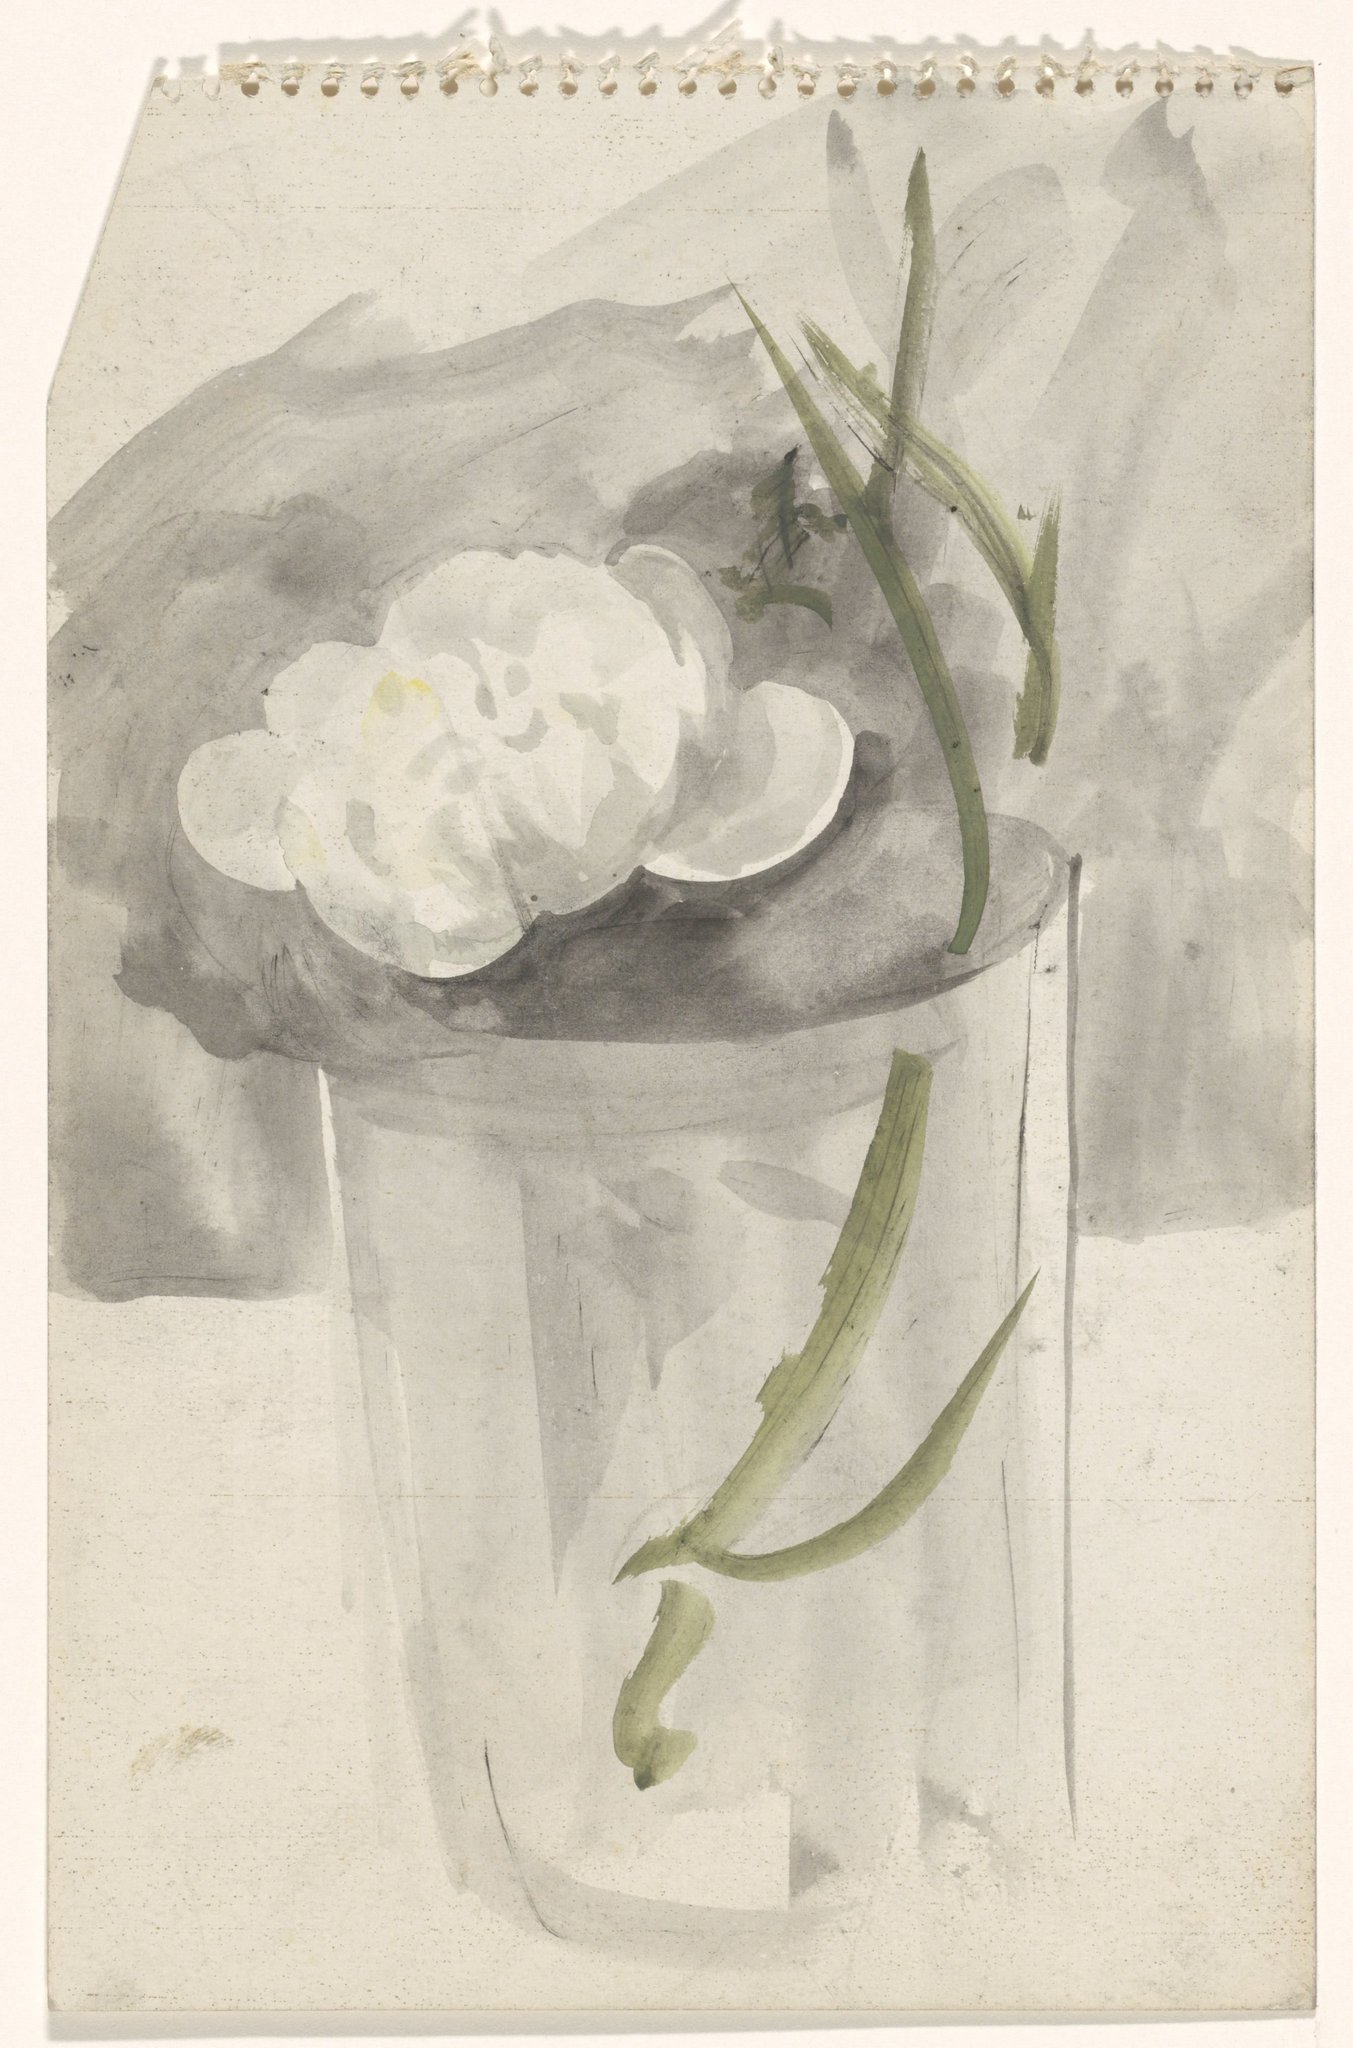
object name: drawing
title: Witte bloem in een glas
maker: carel adolph lion cachet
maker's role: draughtsman, print maker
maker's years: 1864-1945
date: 1874-1945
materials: paper, watercolor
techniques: brush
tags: flowers